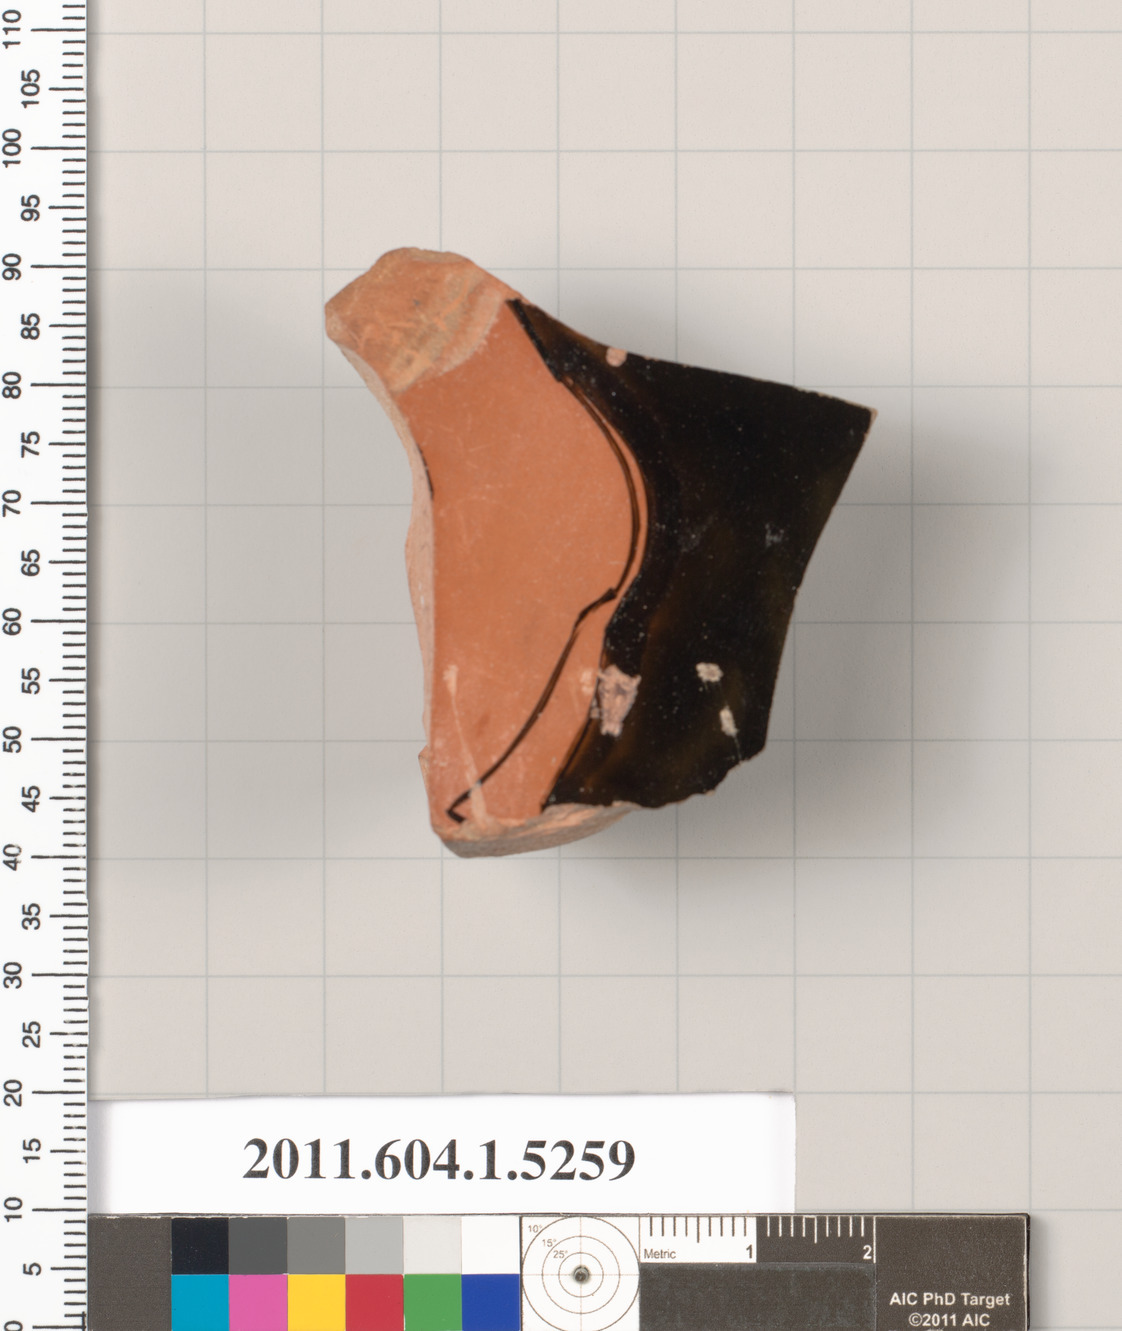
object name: kylix fragment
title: Terracotta fragment of a kylix (drinking cup)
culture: greek, attic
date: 520-500 BCE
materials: terracotta